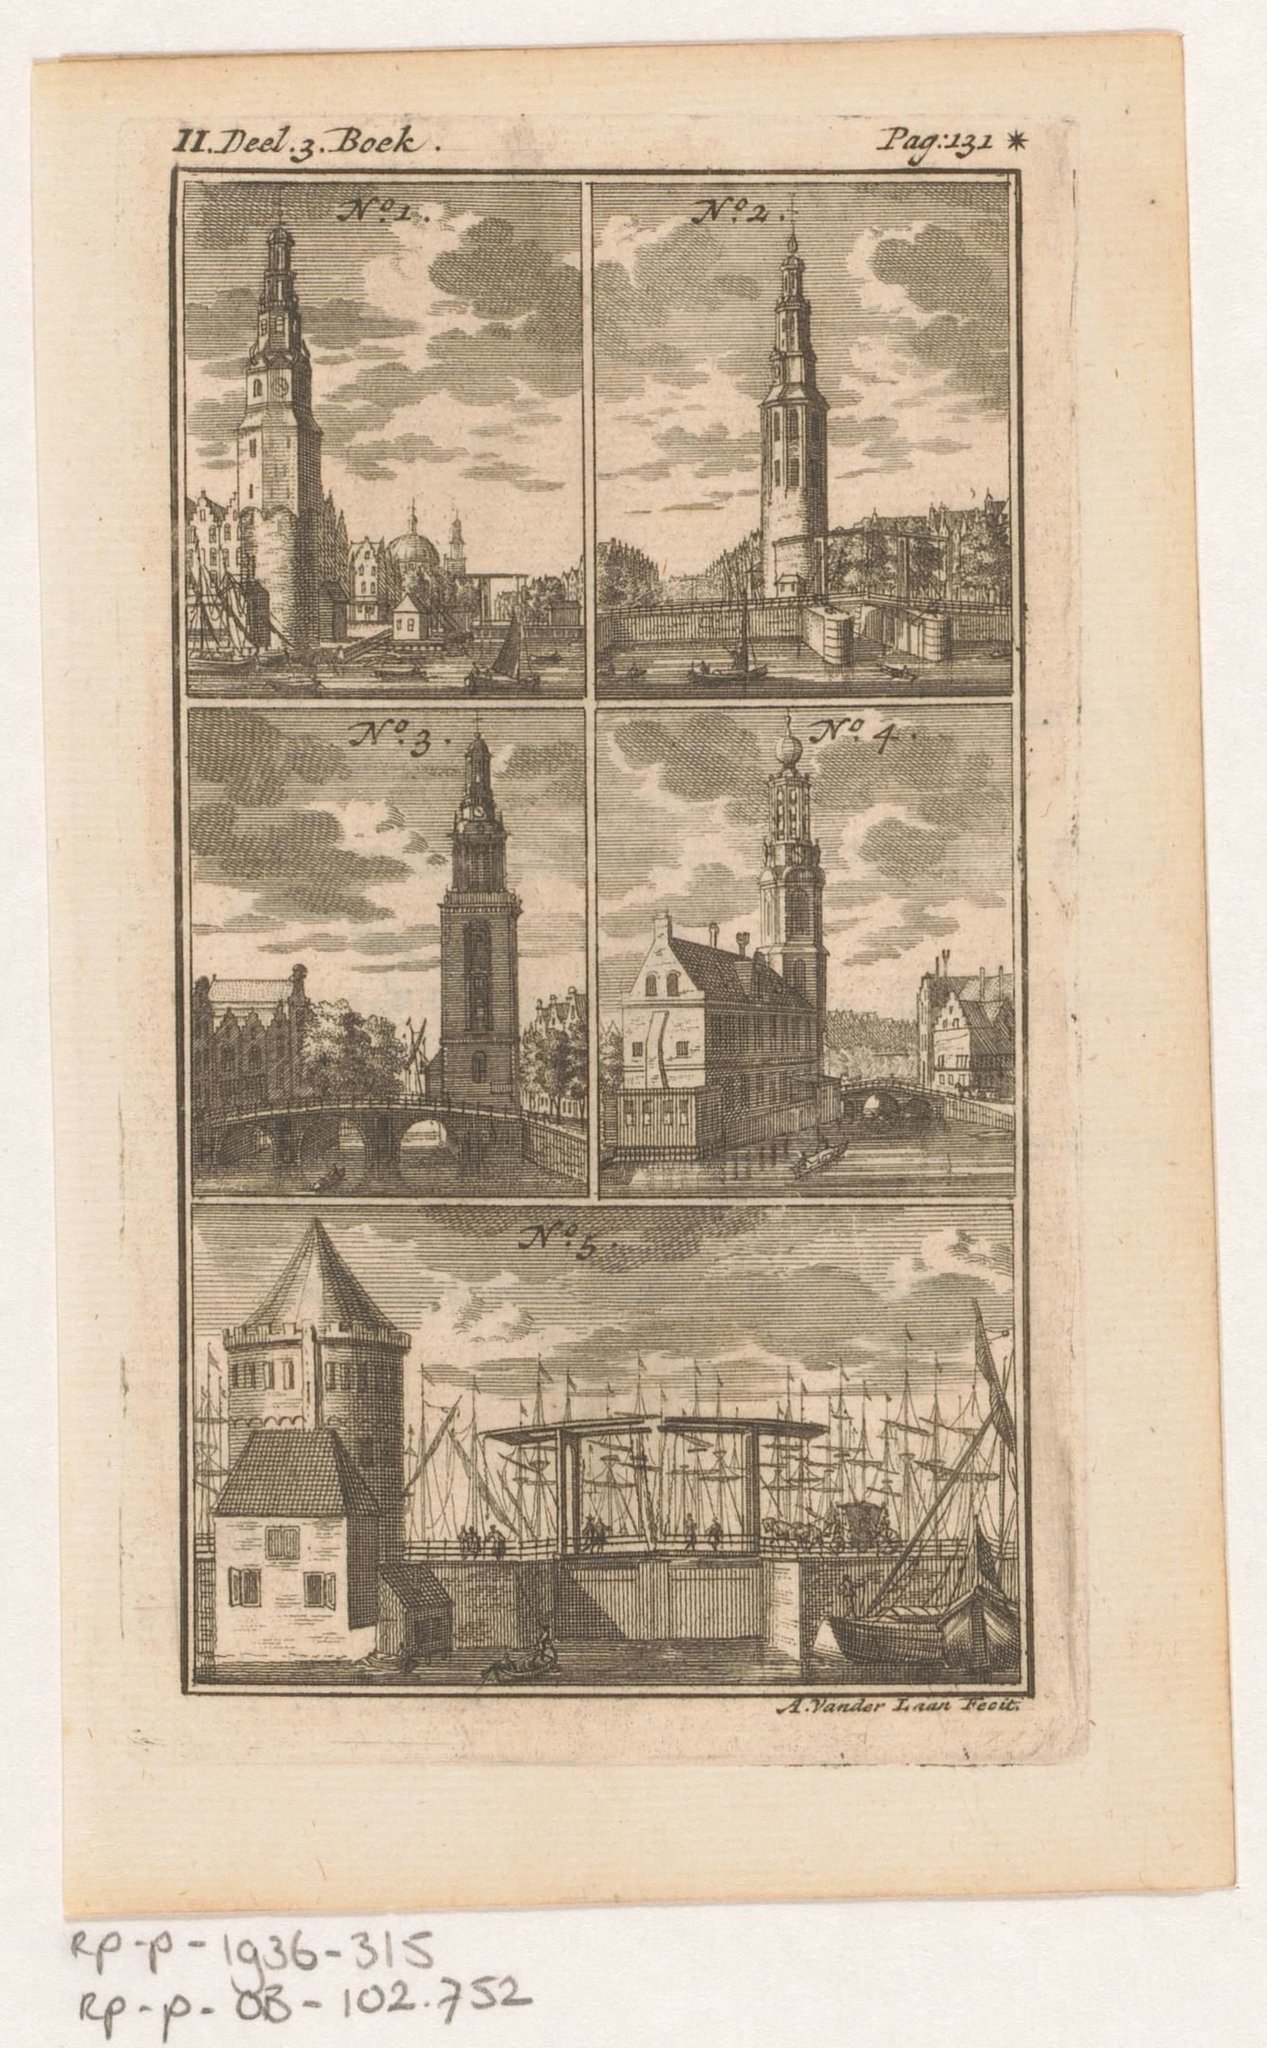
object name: book illustration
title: Torens te Amsterdam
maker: adolf van der laan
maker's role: draughtsman, print maker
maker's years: 1689-1742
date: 1723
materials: paper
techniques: etching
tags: tower, clock tower ~ monumental adornment, civic architecture; edifices; dwellings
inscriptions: collector's mark: Lugt 2760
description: Vijf genummerde illustraties van torens te Amsterdam: Haringpakkerstoren, Montelbaanstoren, Jan Roodenpoortstoren, Munttoren, Schreierstoren. De torens zijn op het bijbehorende tekstblad voorzien van toelichting. Prent links- en rechtsboven gemerkt: II. Deel. 3. Boek - Pag: 131*.